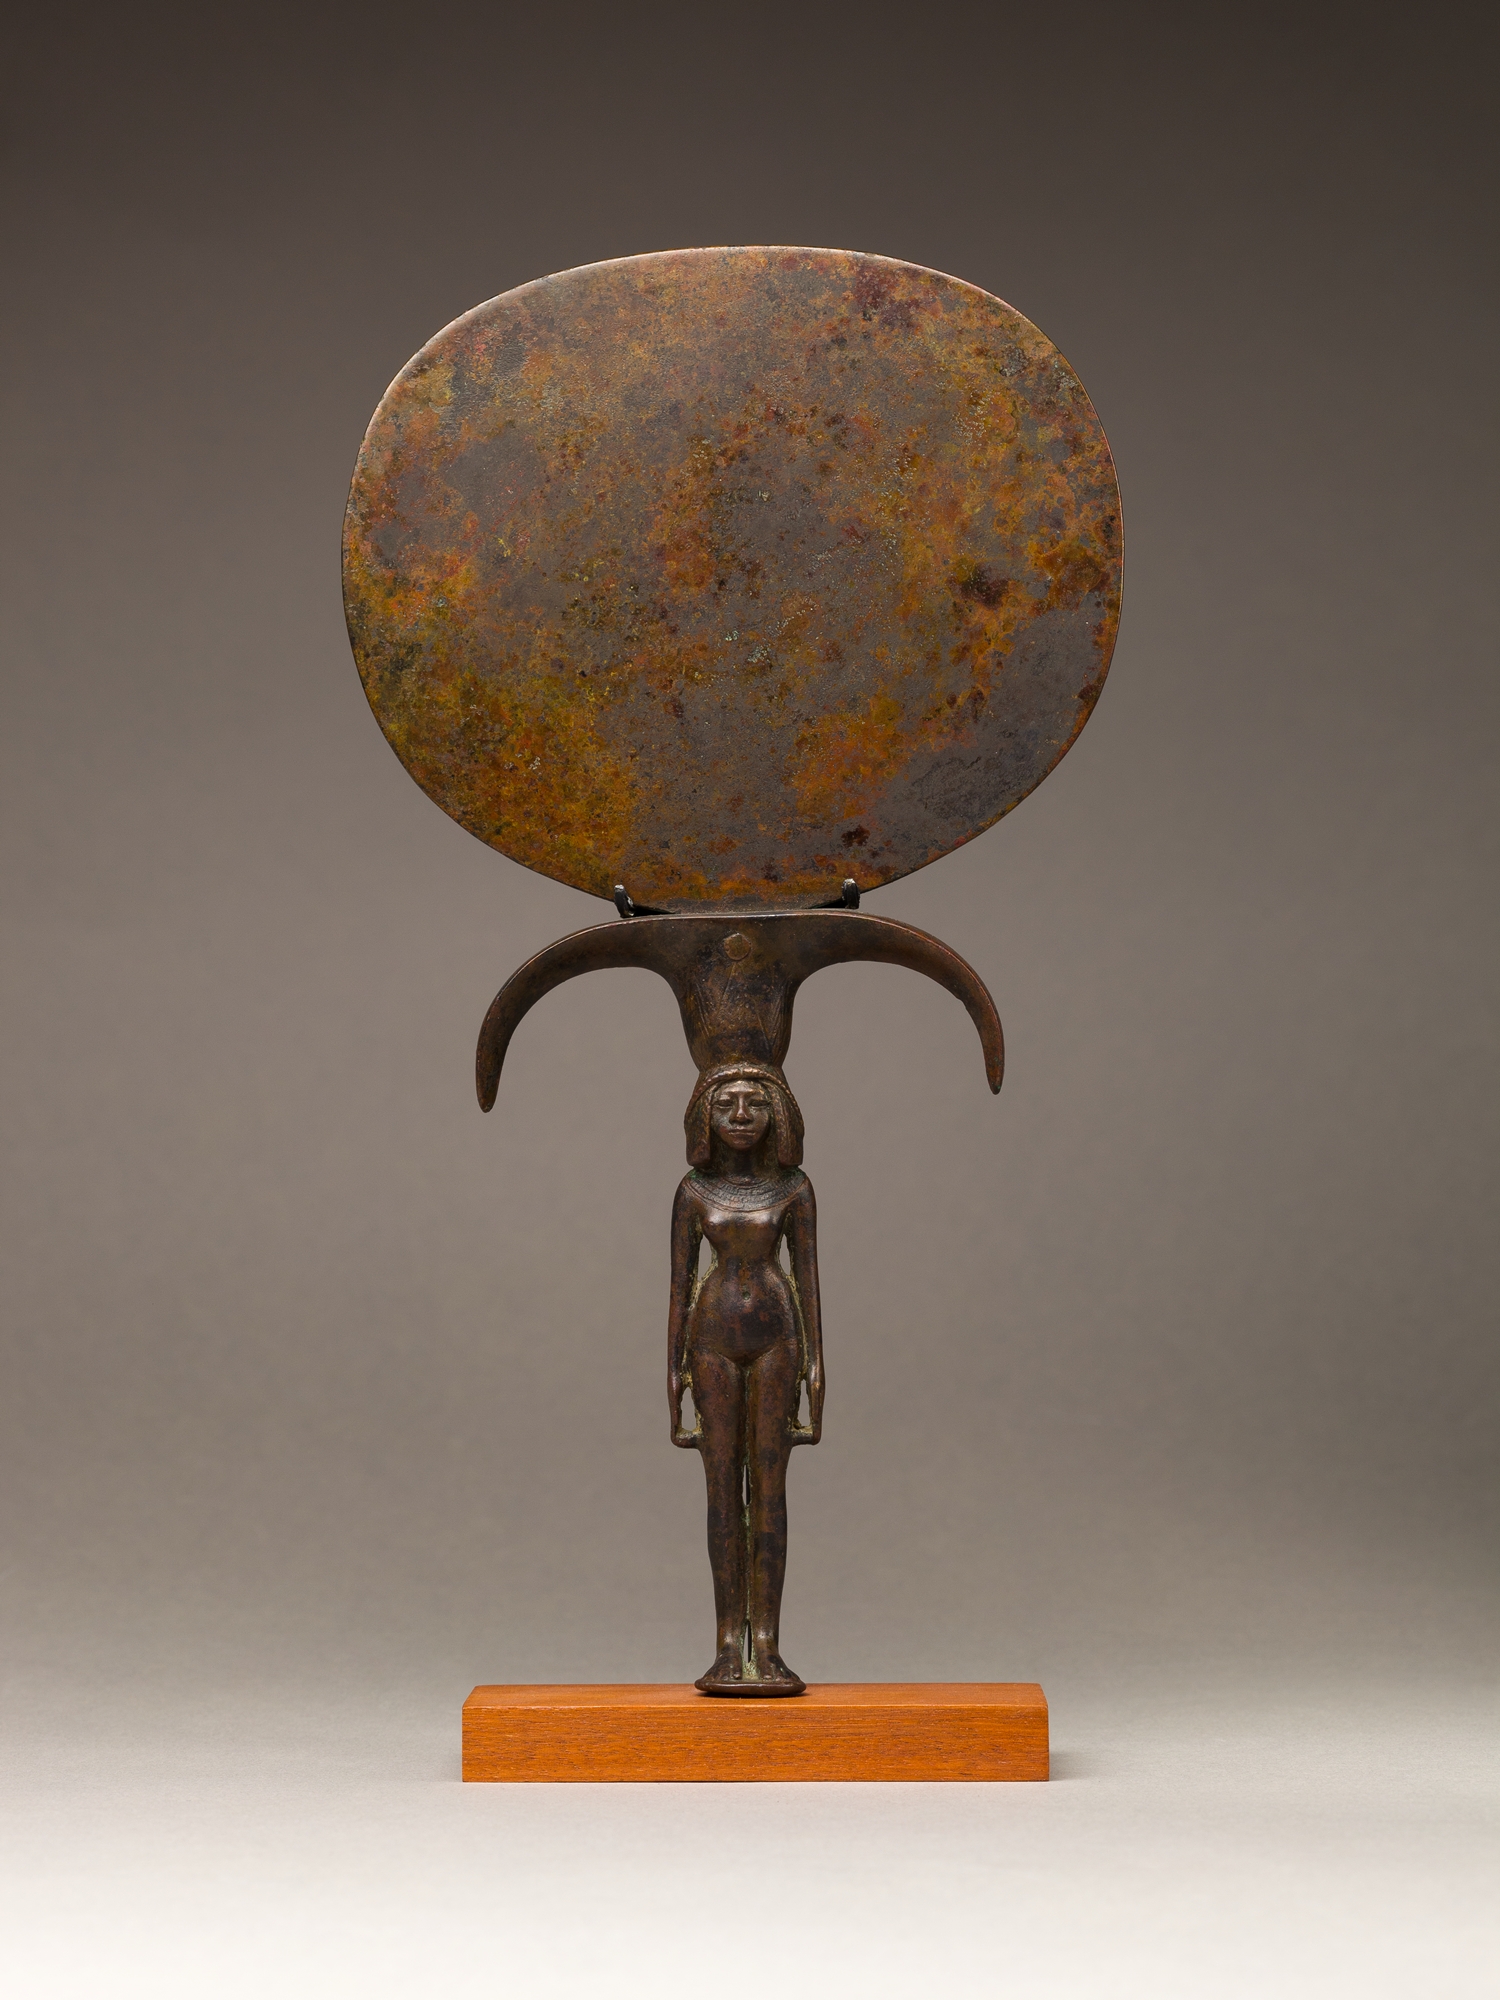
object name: mirror, lotus, woman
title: Mirror with a Handle in the Shape of a Young Woman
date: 1550-1391 BCE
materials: bronze, copper alloy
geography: egypt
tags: women